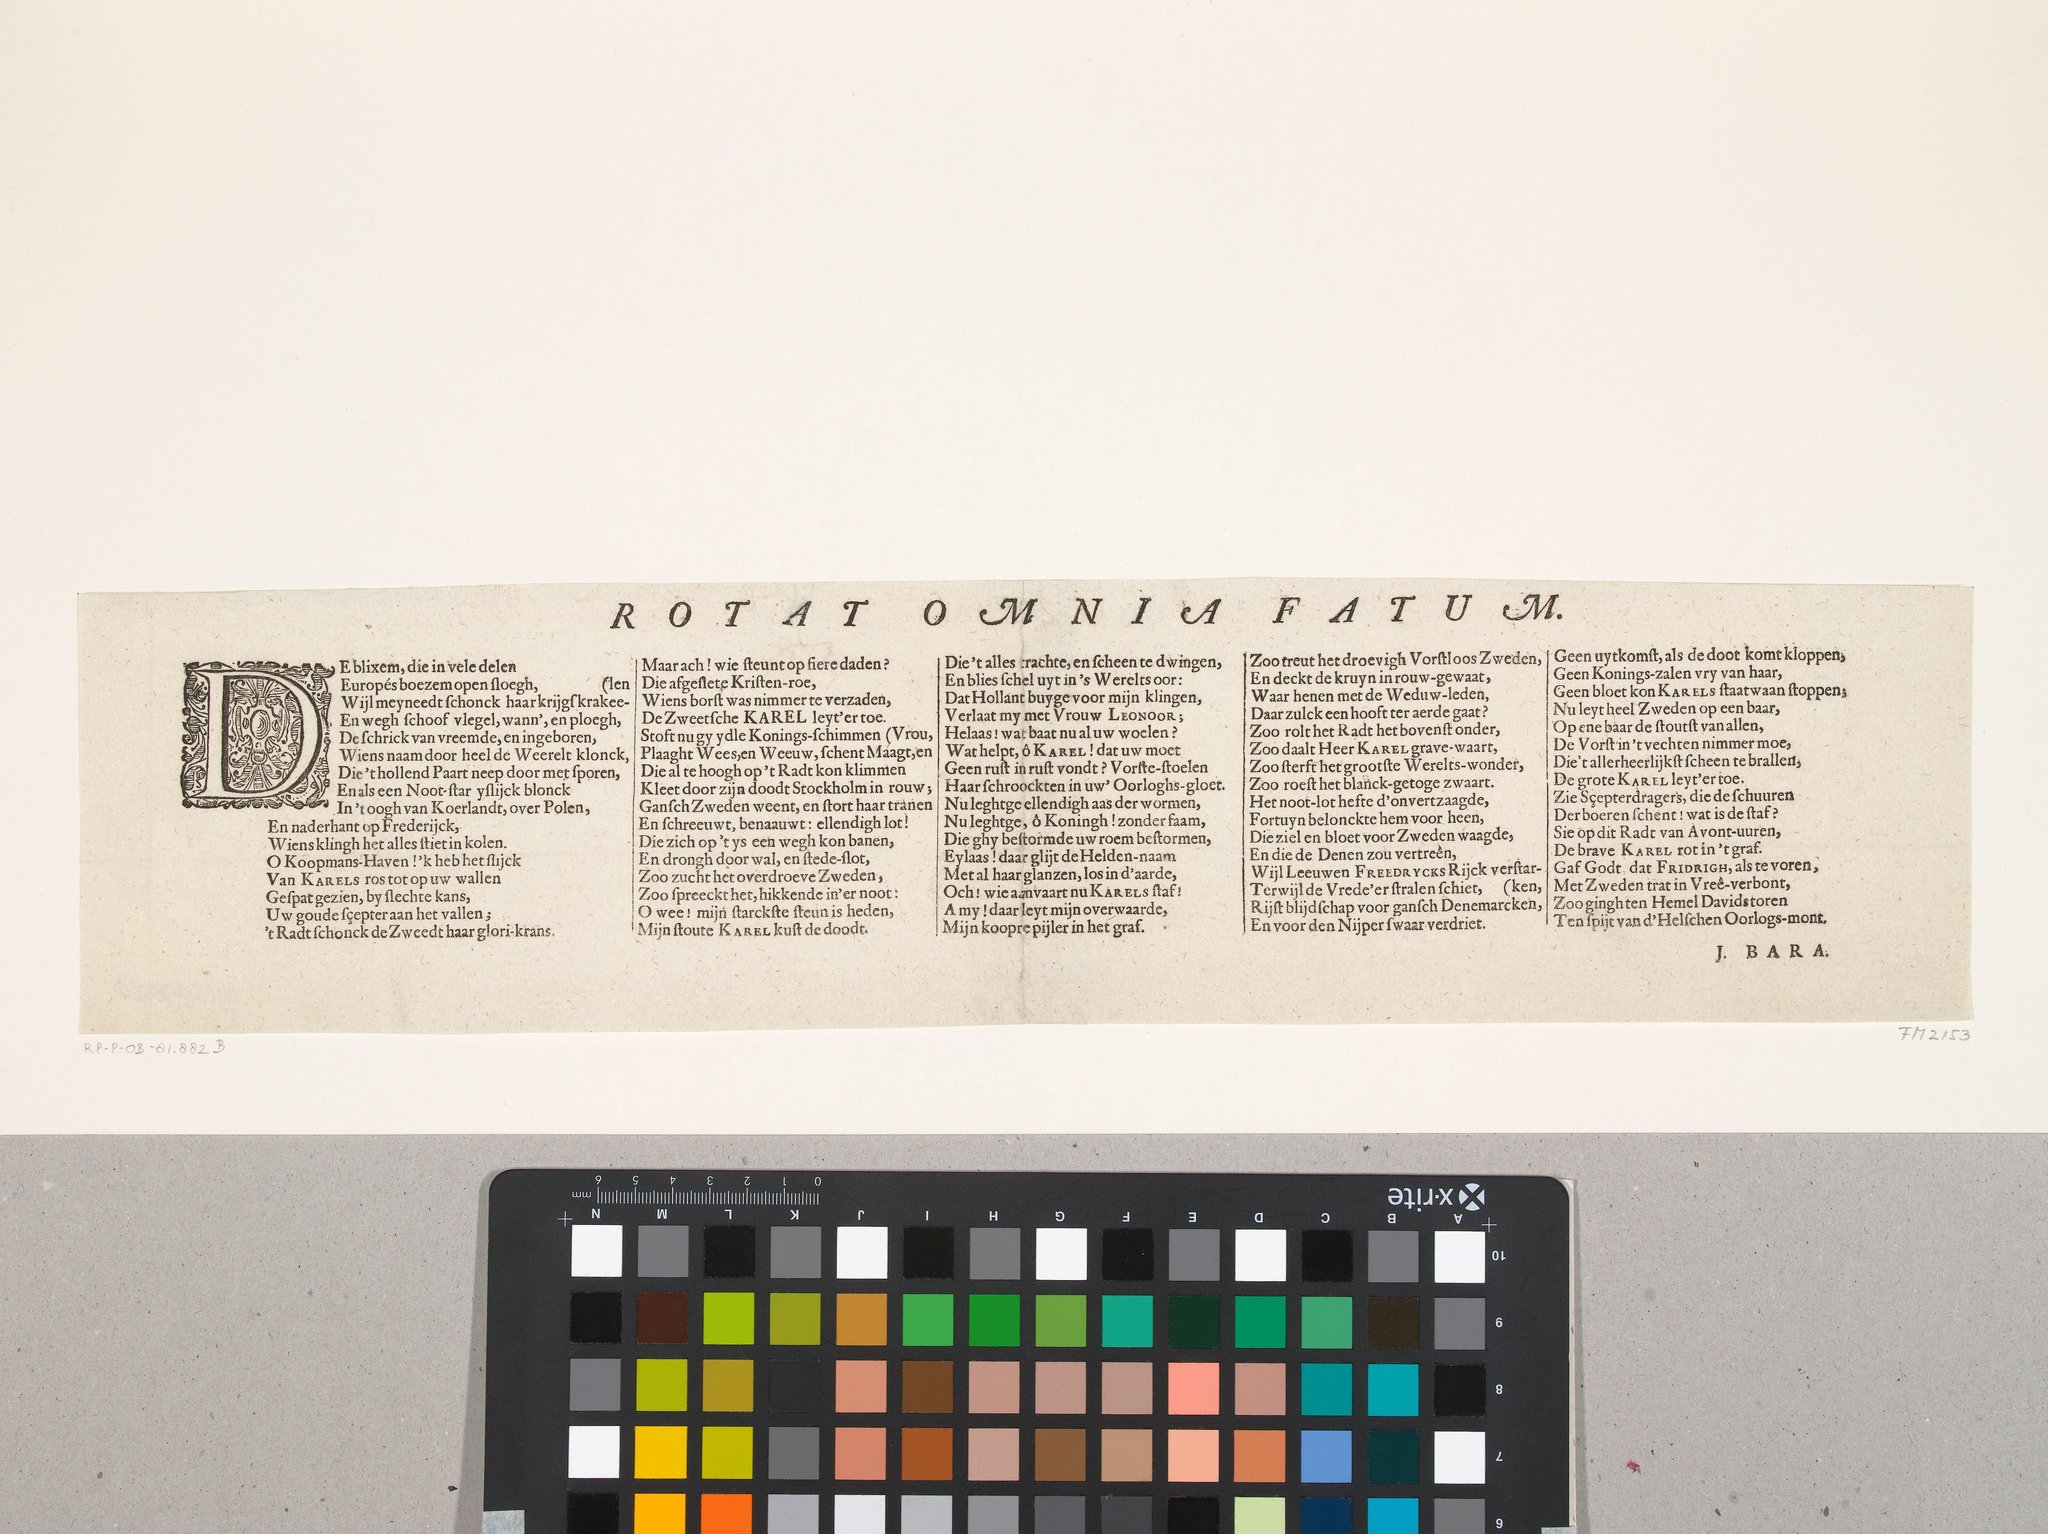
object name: text sheet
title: Rotat Omnium Fatum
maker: jan bara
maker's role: schrijver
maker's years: 1627-1706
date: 1660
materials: paper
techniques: letterpress printing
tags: nyköping, göteborg, koning, karel x gustaaf (koning van zweden)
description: Tekstblad bij de prent met de allegorie op de dood van de Zweedse koning Karel X Gustaaf, 23 februari 1660. Vers in 5 kolommen.